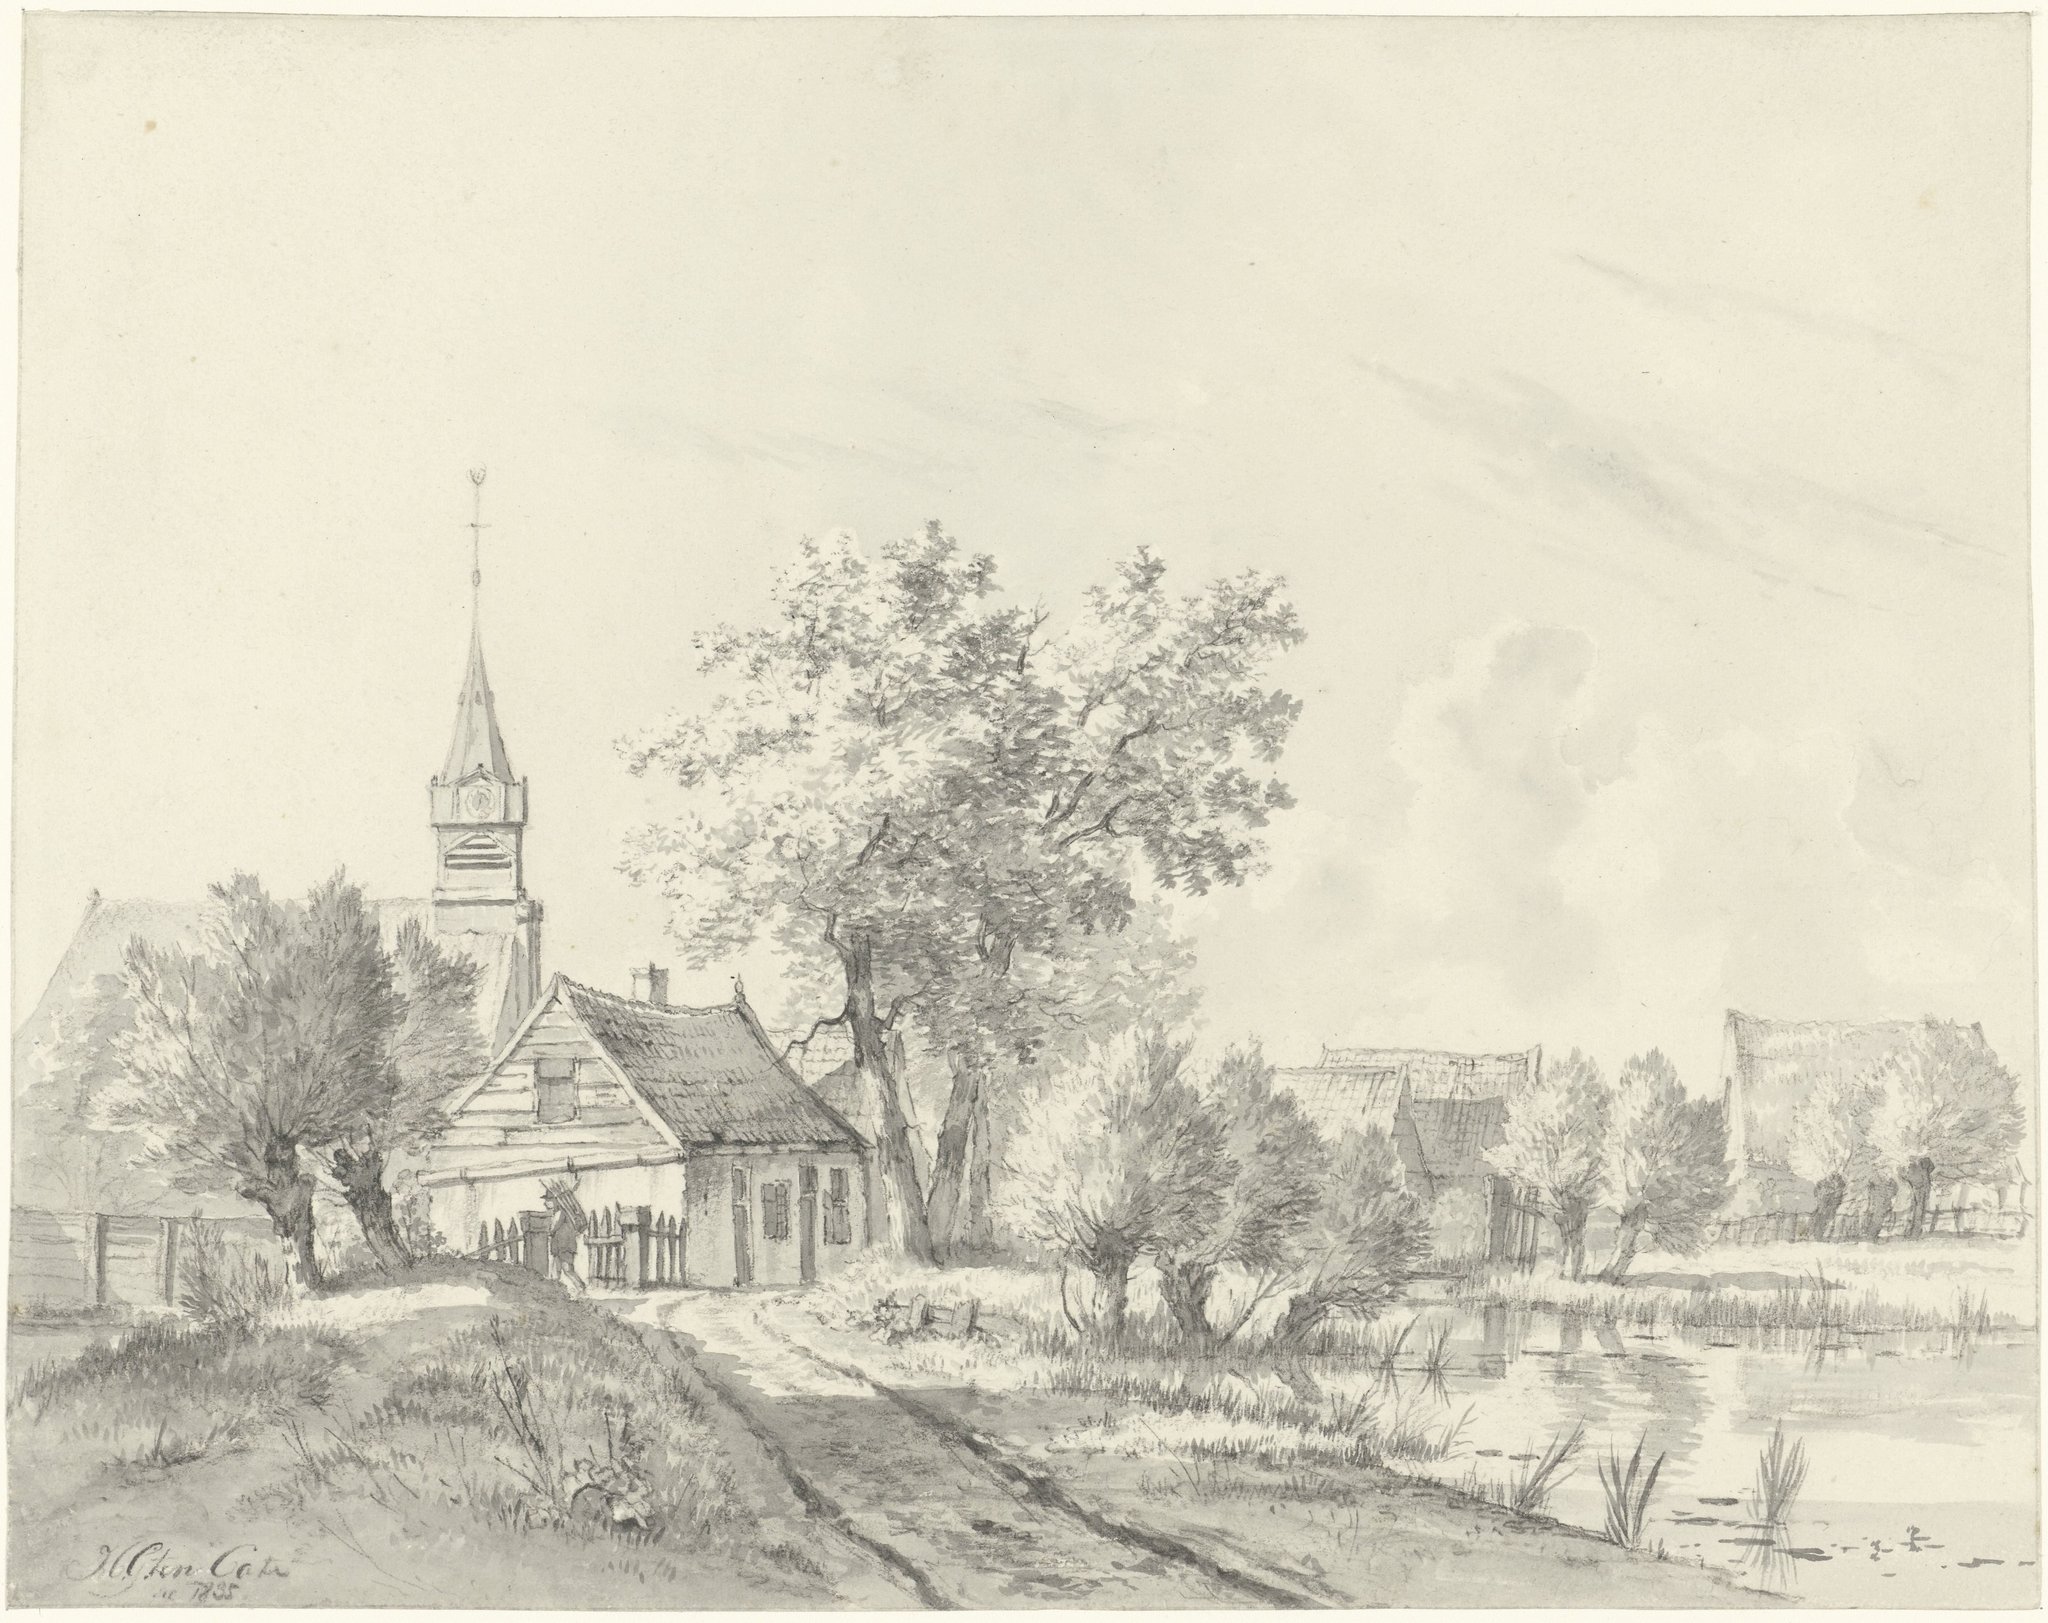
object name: drawing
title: Sloten, gezien vanaf de Osdorperweg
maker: hendrik gerrit ten cate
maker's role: draughtsman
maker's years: 1803-1856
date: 1835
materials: chalk, paper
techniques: brush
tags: prospect of village, silhouette of village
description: Het dorp Sloten, gezien vanaf de Osdorperweg.